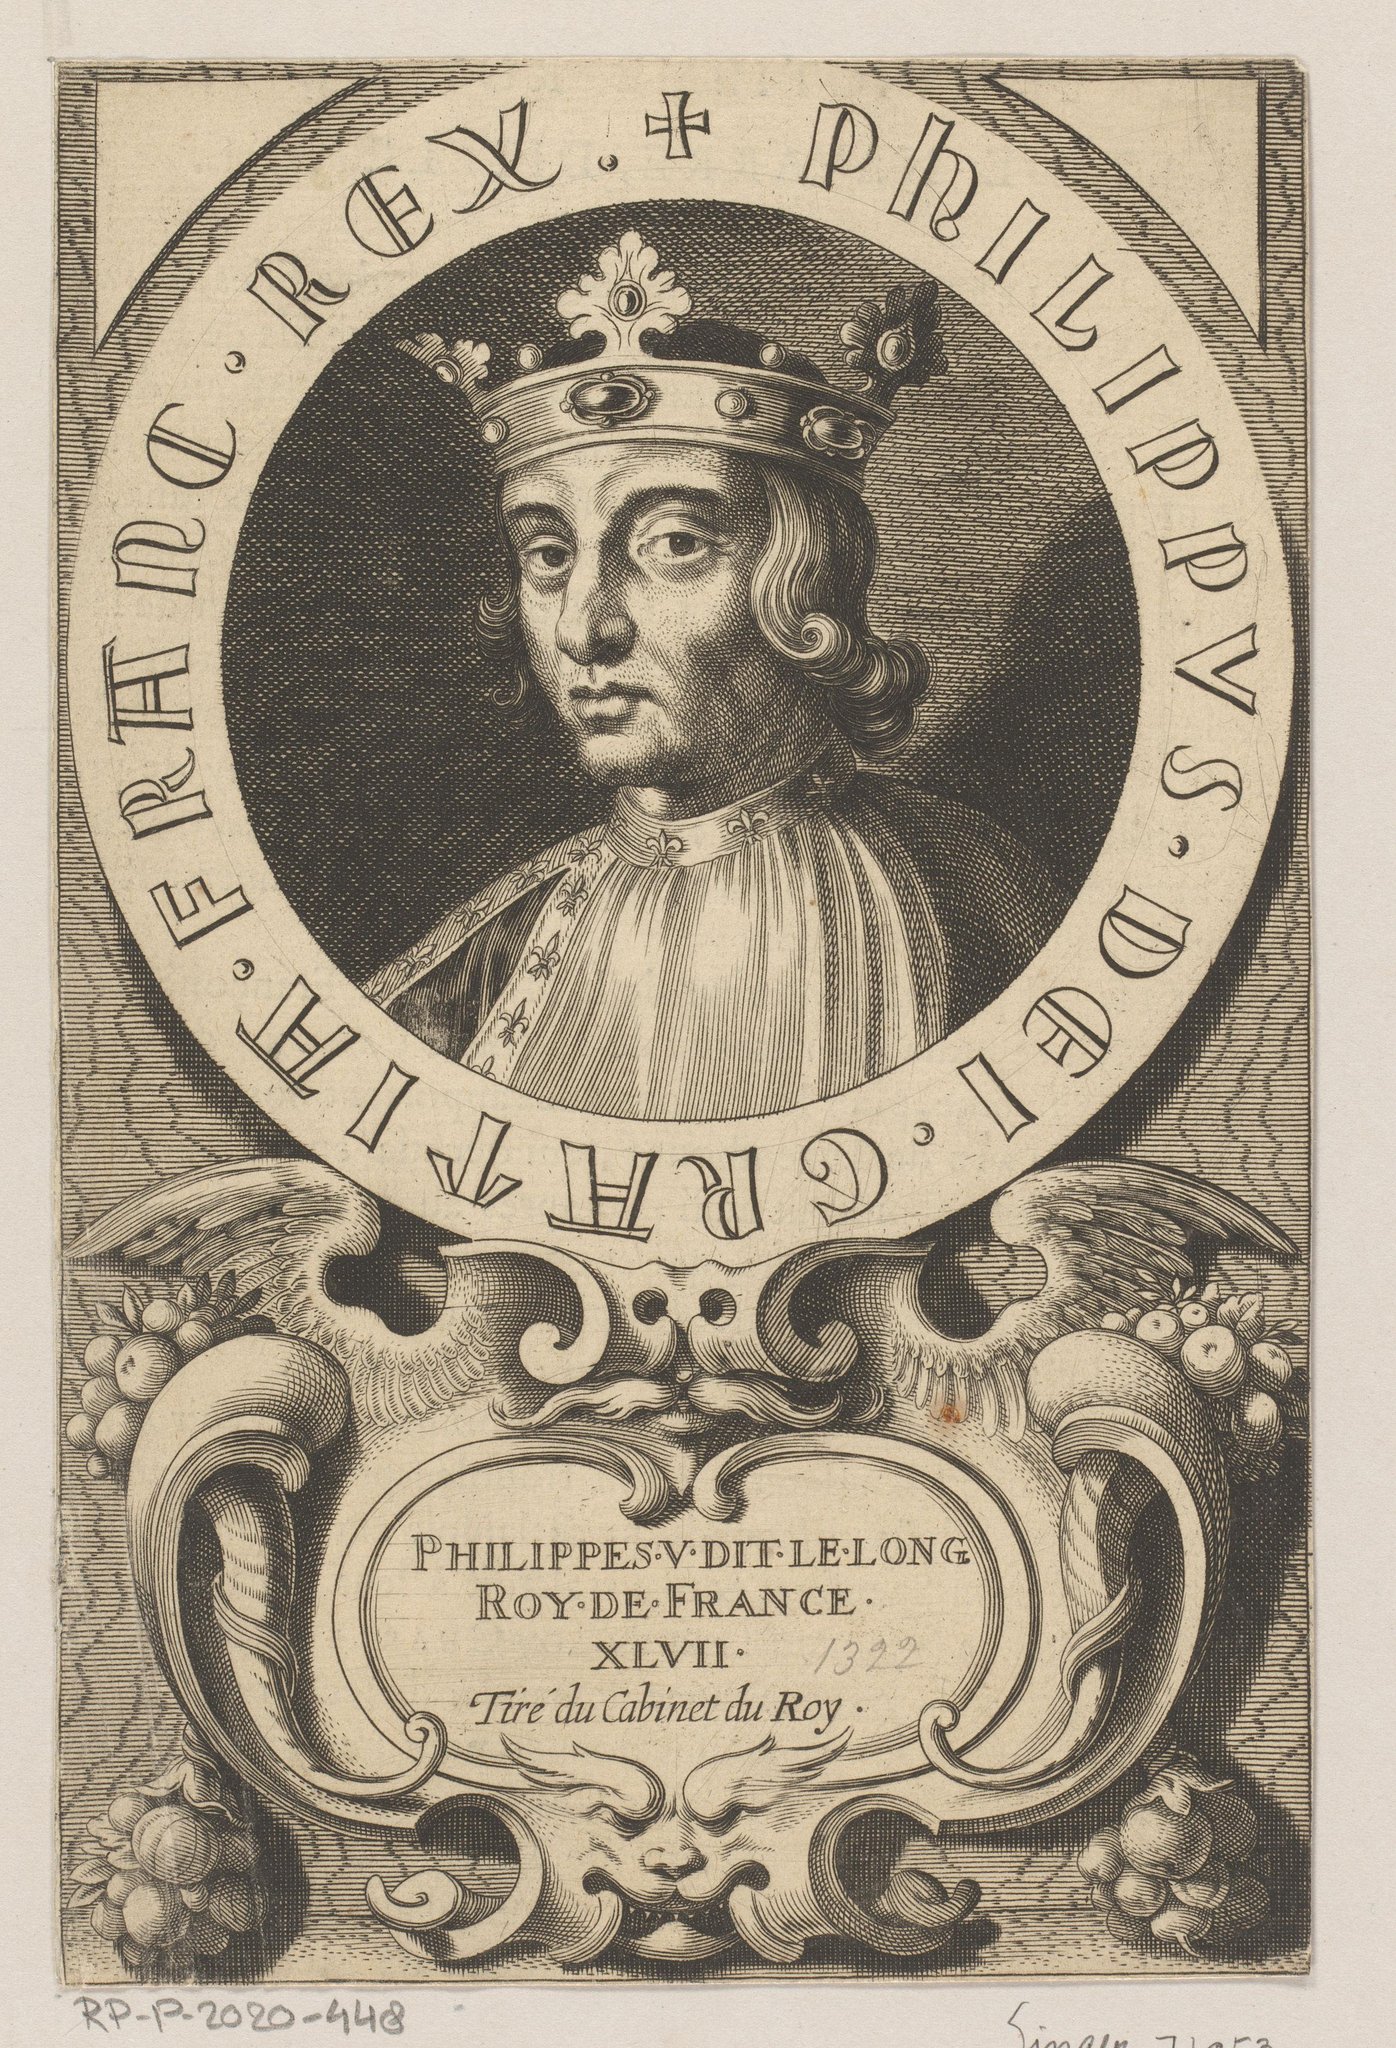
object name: print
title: Portret van Filips V, koning van Frankrijk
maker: jacques de bie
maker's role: print maker, publisher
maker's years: 1581-1647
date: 1634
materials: paper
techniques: engraving, letterpress printing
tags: lyon, historical persons, ruler, sovereign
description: Prent waarschijnlijk voor het eerst verschenen in: Bie, Jacques de. Les vrais portraits des rois de France (...). 3 dln. Parijs: Jacques de Bie en Pierre Rocolet, 1634, dl. 3. Prent ook gebruikt in latere publicaties.